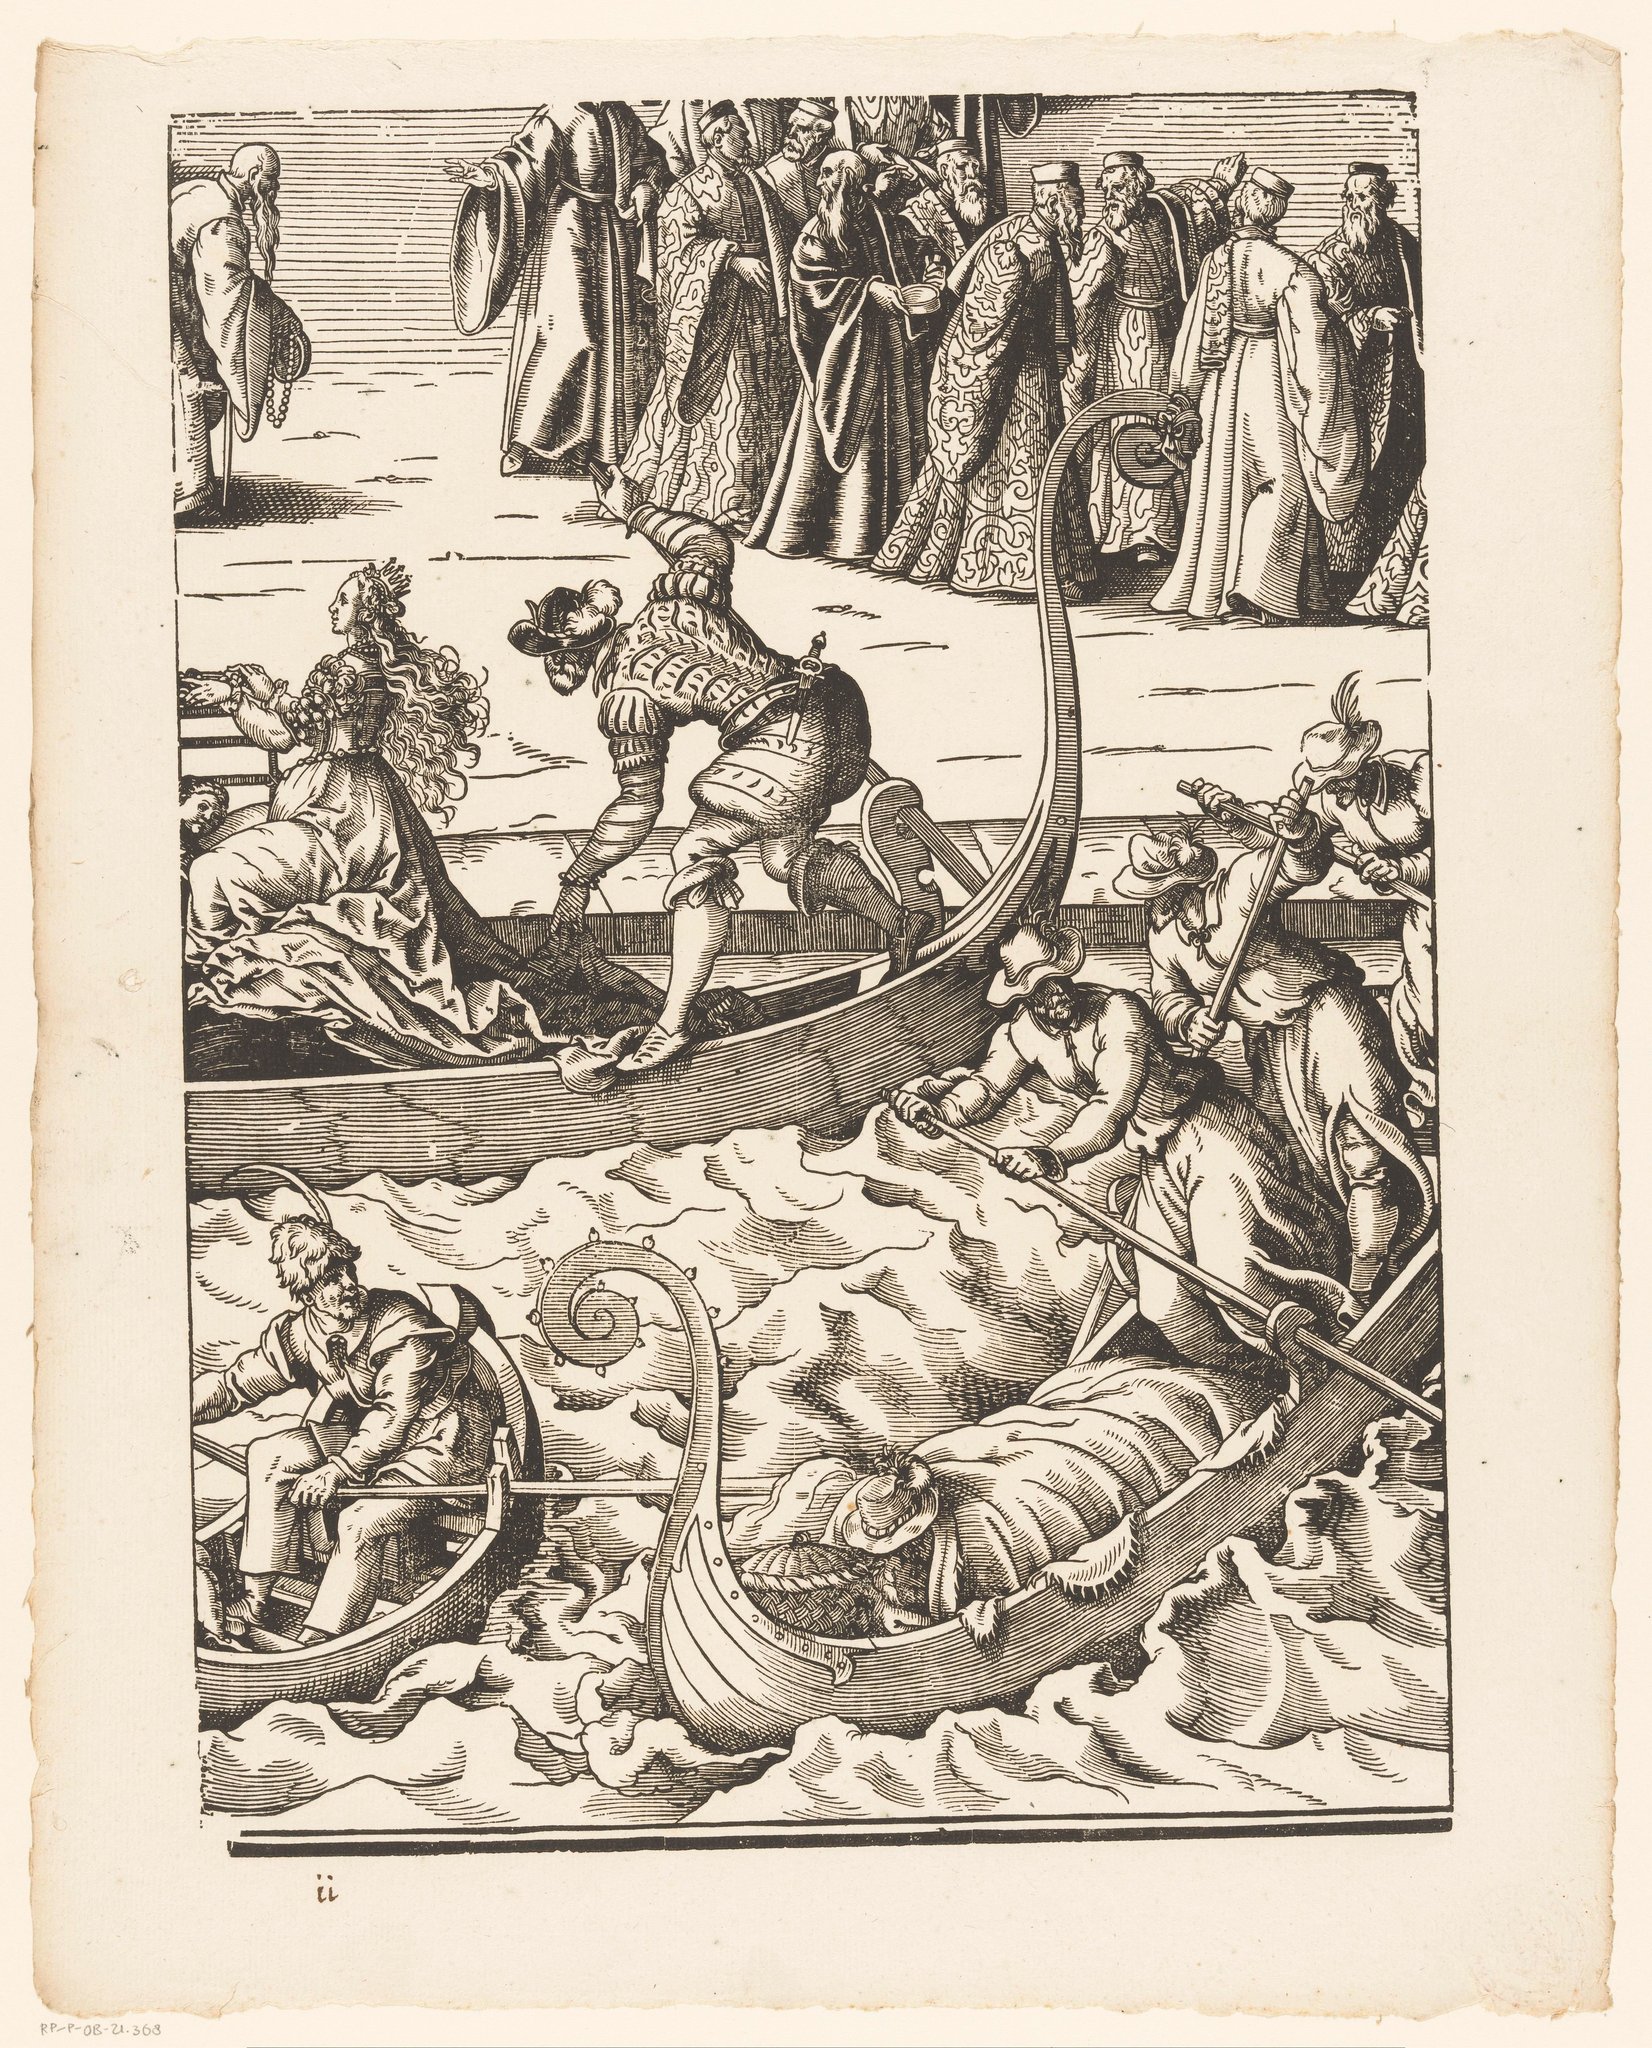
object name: print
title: Festa della Sensa (elfde gedeelte)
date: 1679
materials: paper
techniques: woodcut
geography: nuremberg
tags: city-view in general; 'veduta', bride (in wedding-dress), procession ~ christian religion, gondola, venice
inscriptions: collector's mark: Lugt 240, number: ‘ii’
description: Elfde gedeelte van een grote voorstelling van de Festa della Sensa. De voorstelling is gedrukt van veertien blokken, de titel van vijf blokken en het onderschrift bestaat uit vijf delen van elk drie kolommen Duits tekst. In de collectie Rijksmuseum bevinden zich twee complete exemplaren inclusief titel en onderschrift. De veertien blokken die samen de voorstelling vormen zijn in de titels met de klok mee vanaf linksboven genummerd.